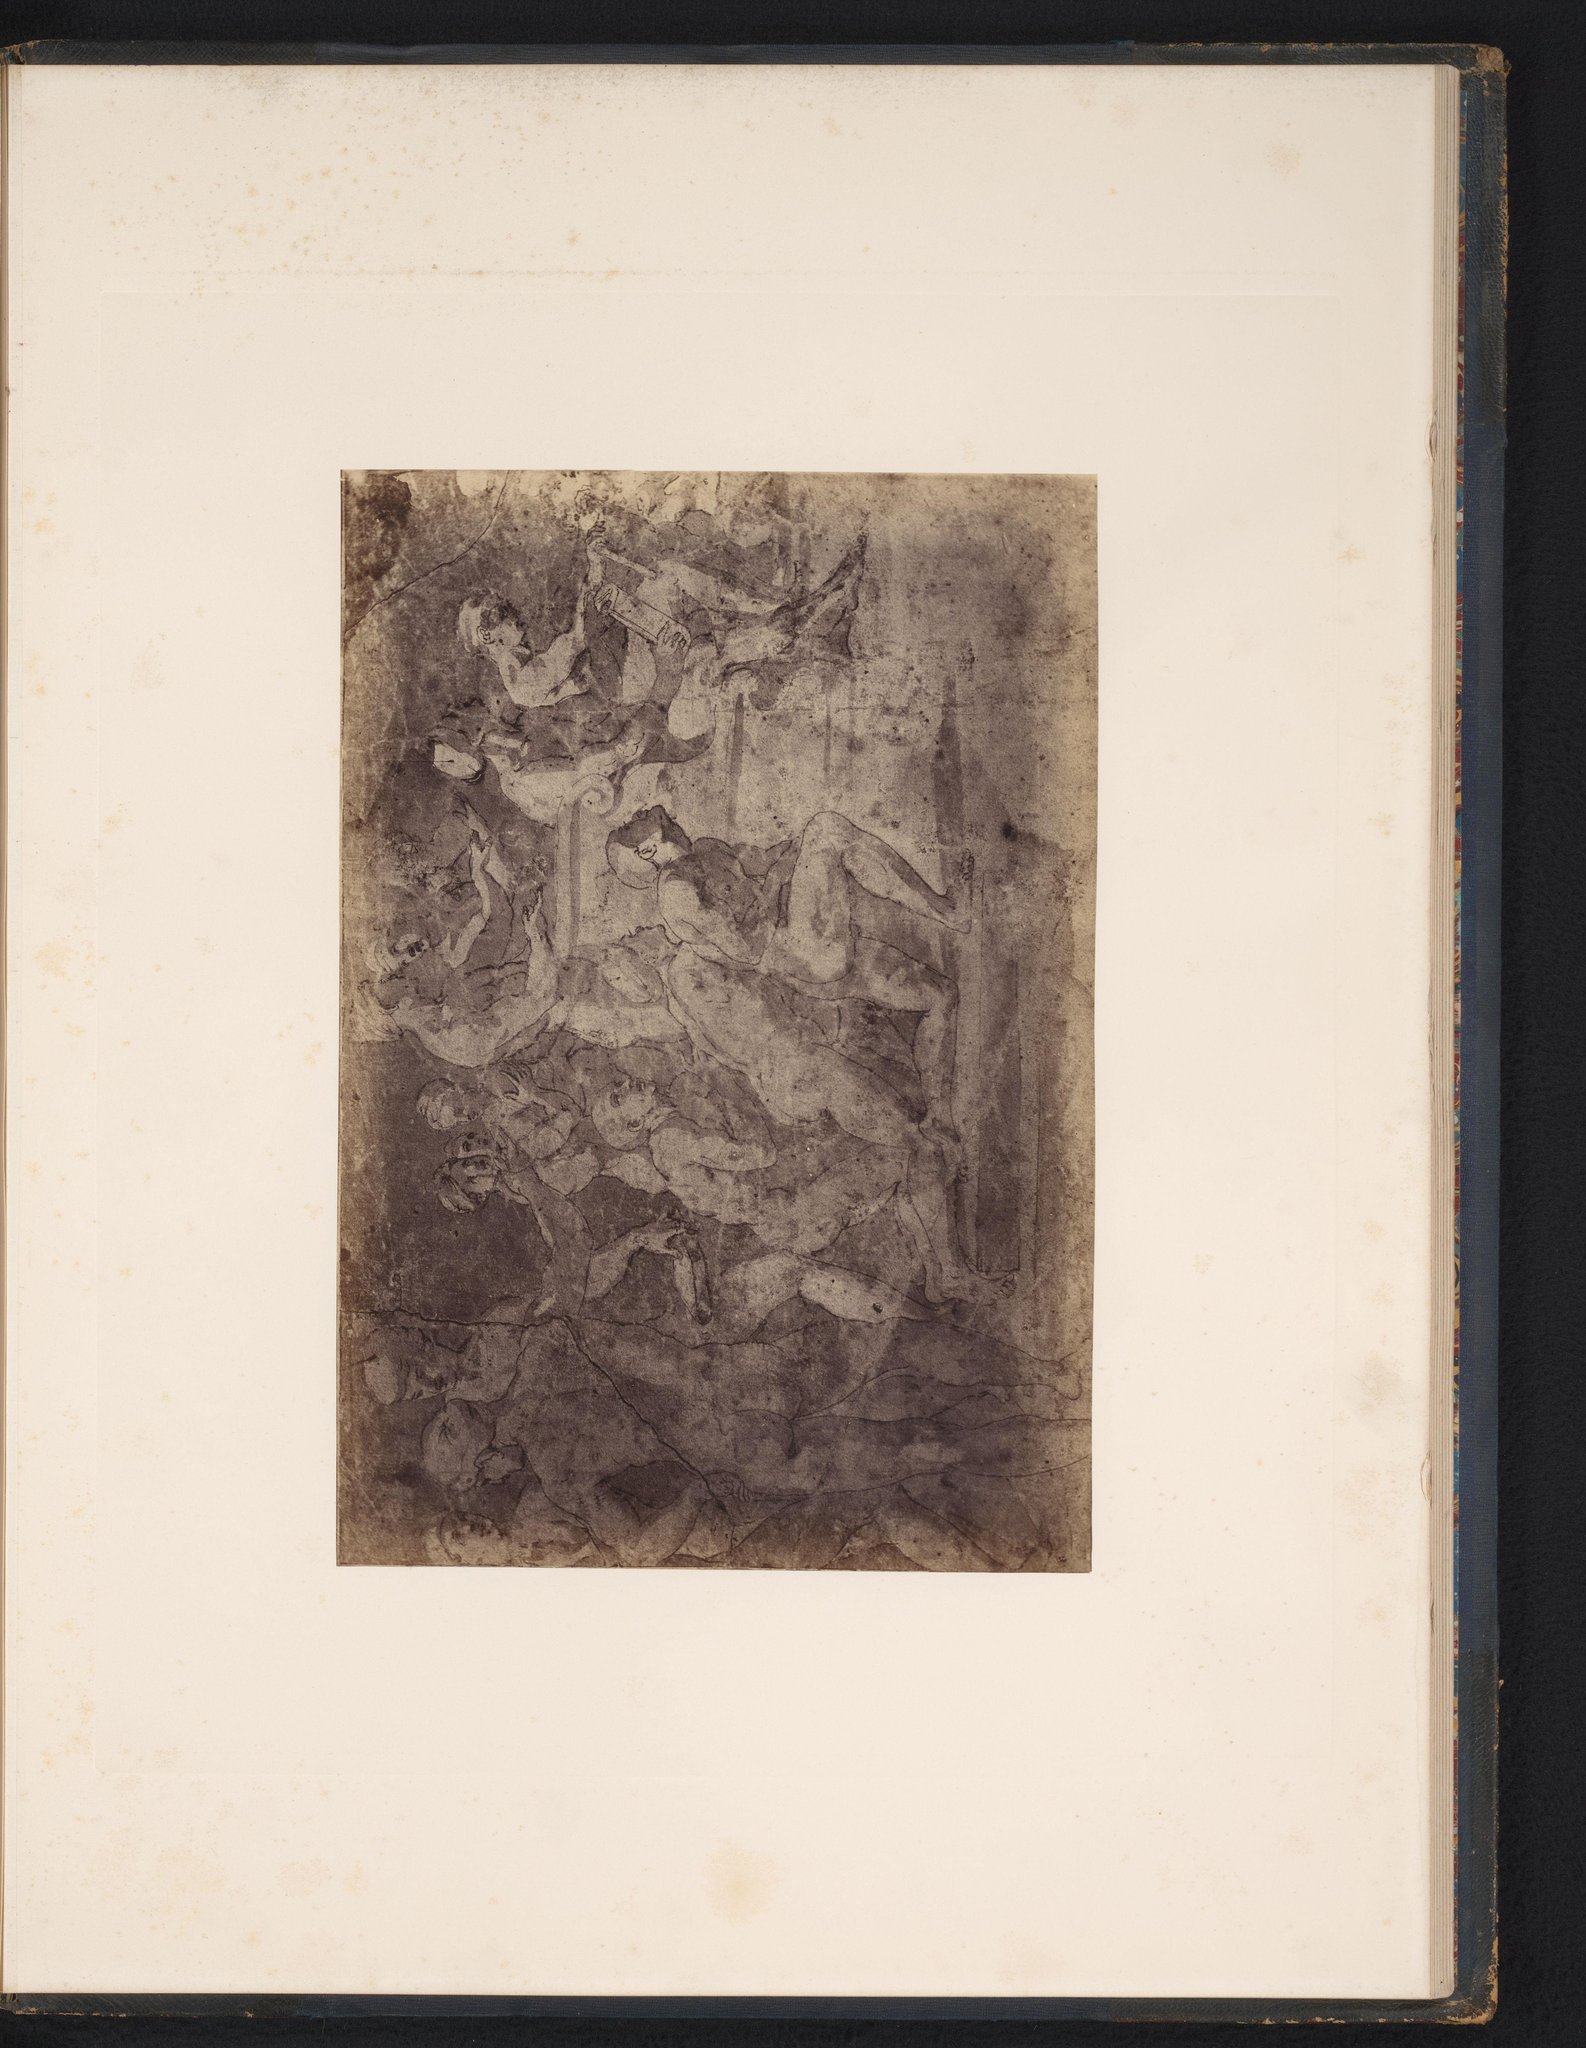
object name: photograph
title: Fotoreproductie van een tekening van Rafaël, leerlingen tijdens college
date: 1852-1857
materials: paper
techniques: albumen print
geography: windsor castle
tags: student